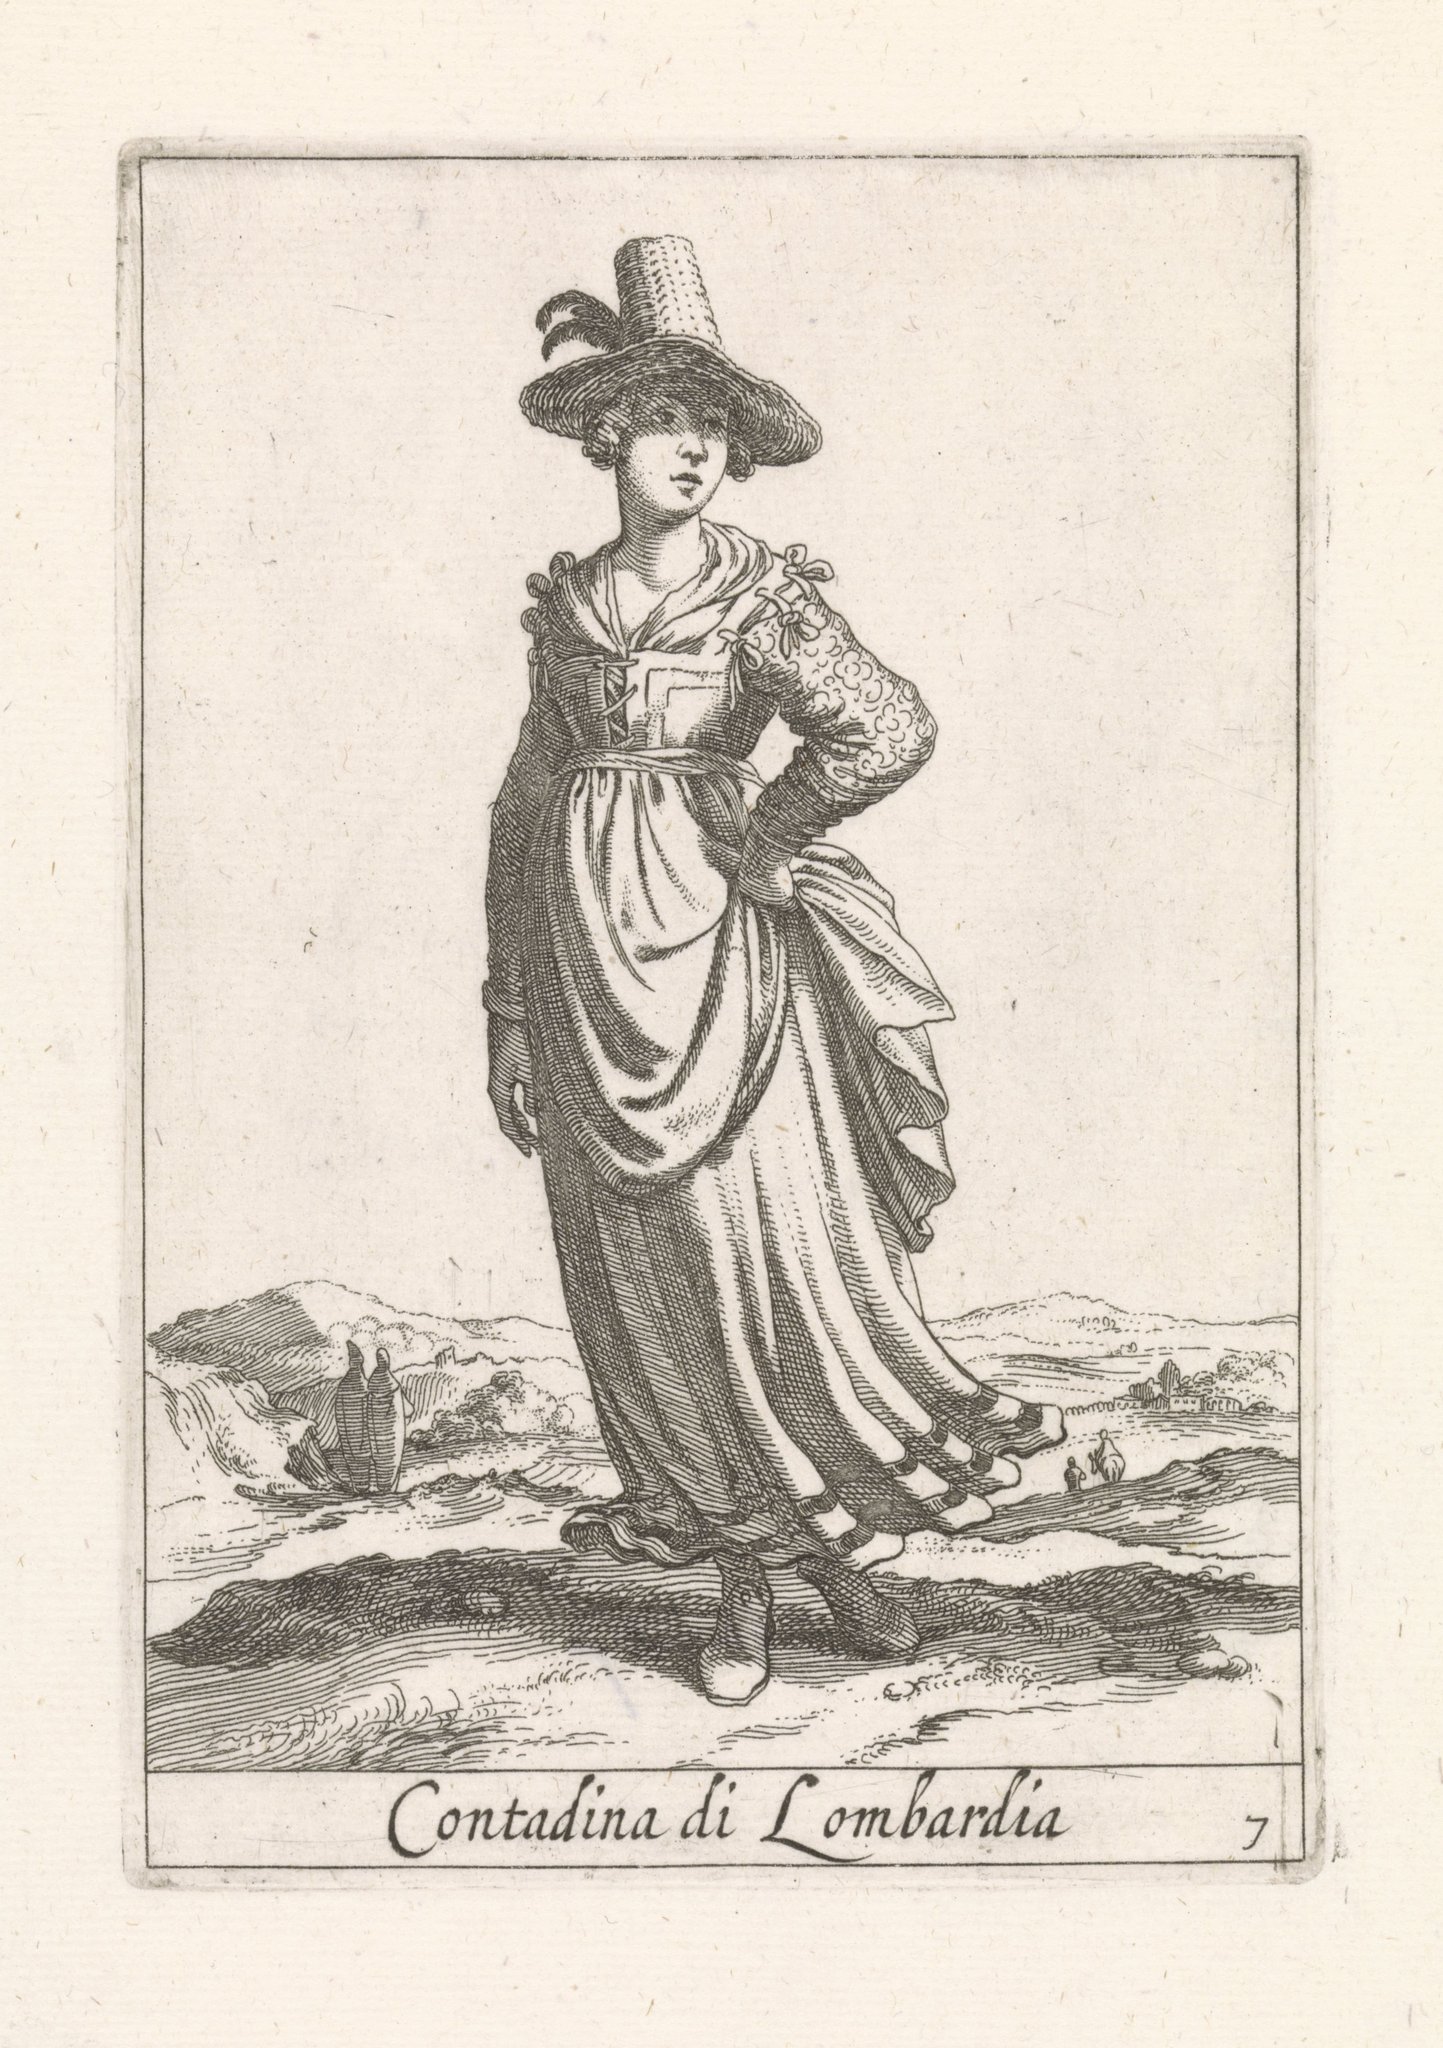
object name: print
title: Kostuums uit Italië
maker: Anonymous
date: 1720-1772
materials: paper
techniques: etching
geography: amsterdam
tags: europeans (with name) (+ costume)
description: Landschap met boerenvrouw, gekleed in mode uit Lombardije, Italië. De boerin is ten voeten uit weergegeven en houdt met haar linkerhand haar schort op. Ze draagt een japon met geregen lijfje en een grote strohoed. De prent maakt deel uit van een twaalfdelige serie prenten met Italiaanse kostuums.